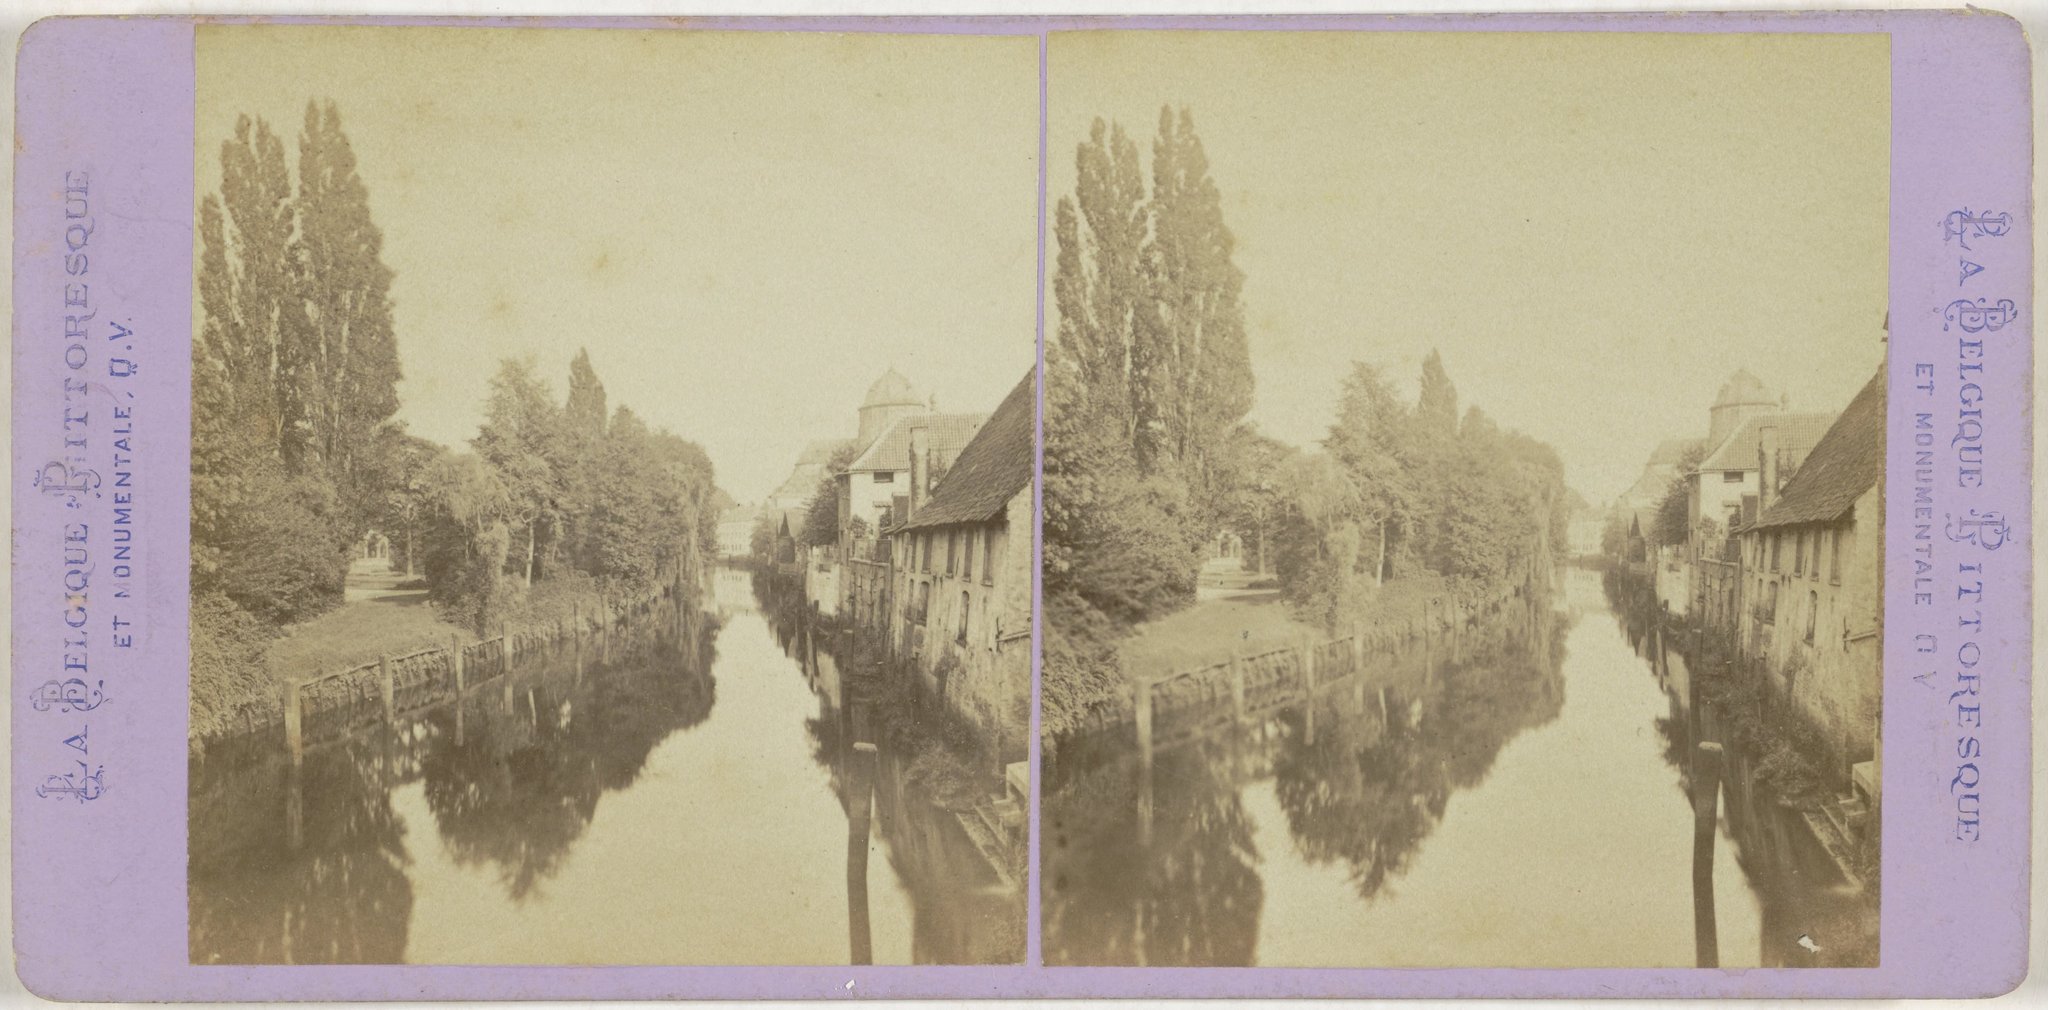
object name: stereograph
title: La Belgique pittoresque et monumentale / Views of Belgium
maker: jules hippolyte quéval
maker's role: publisher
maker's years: 1824-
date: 1866-1870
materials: cardboard, paper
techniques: albumen print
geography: mechelen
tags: park, river, botanic garden, 'hortus botanicus'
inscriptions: number: ‘No 1639’